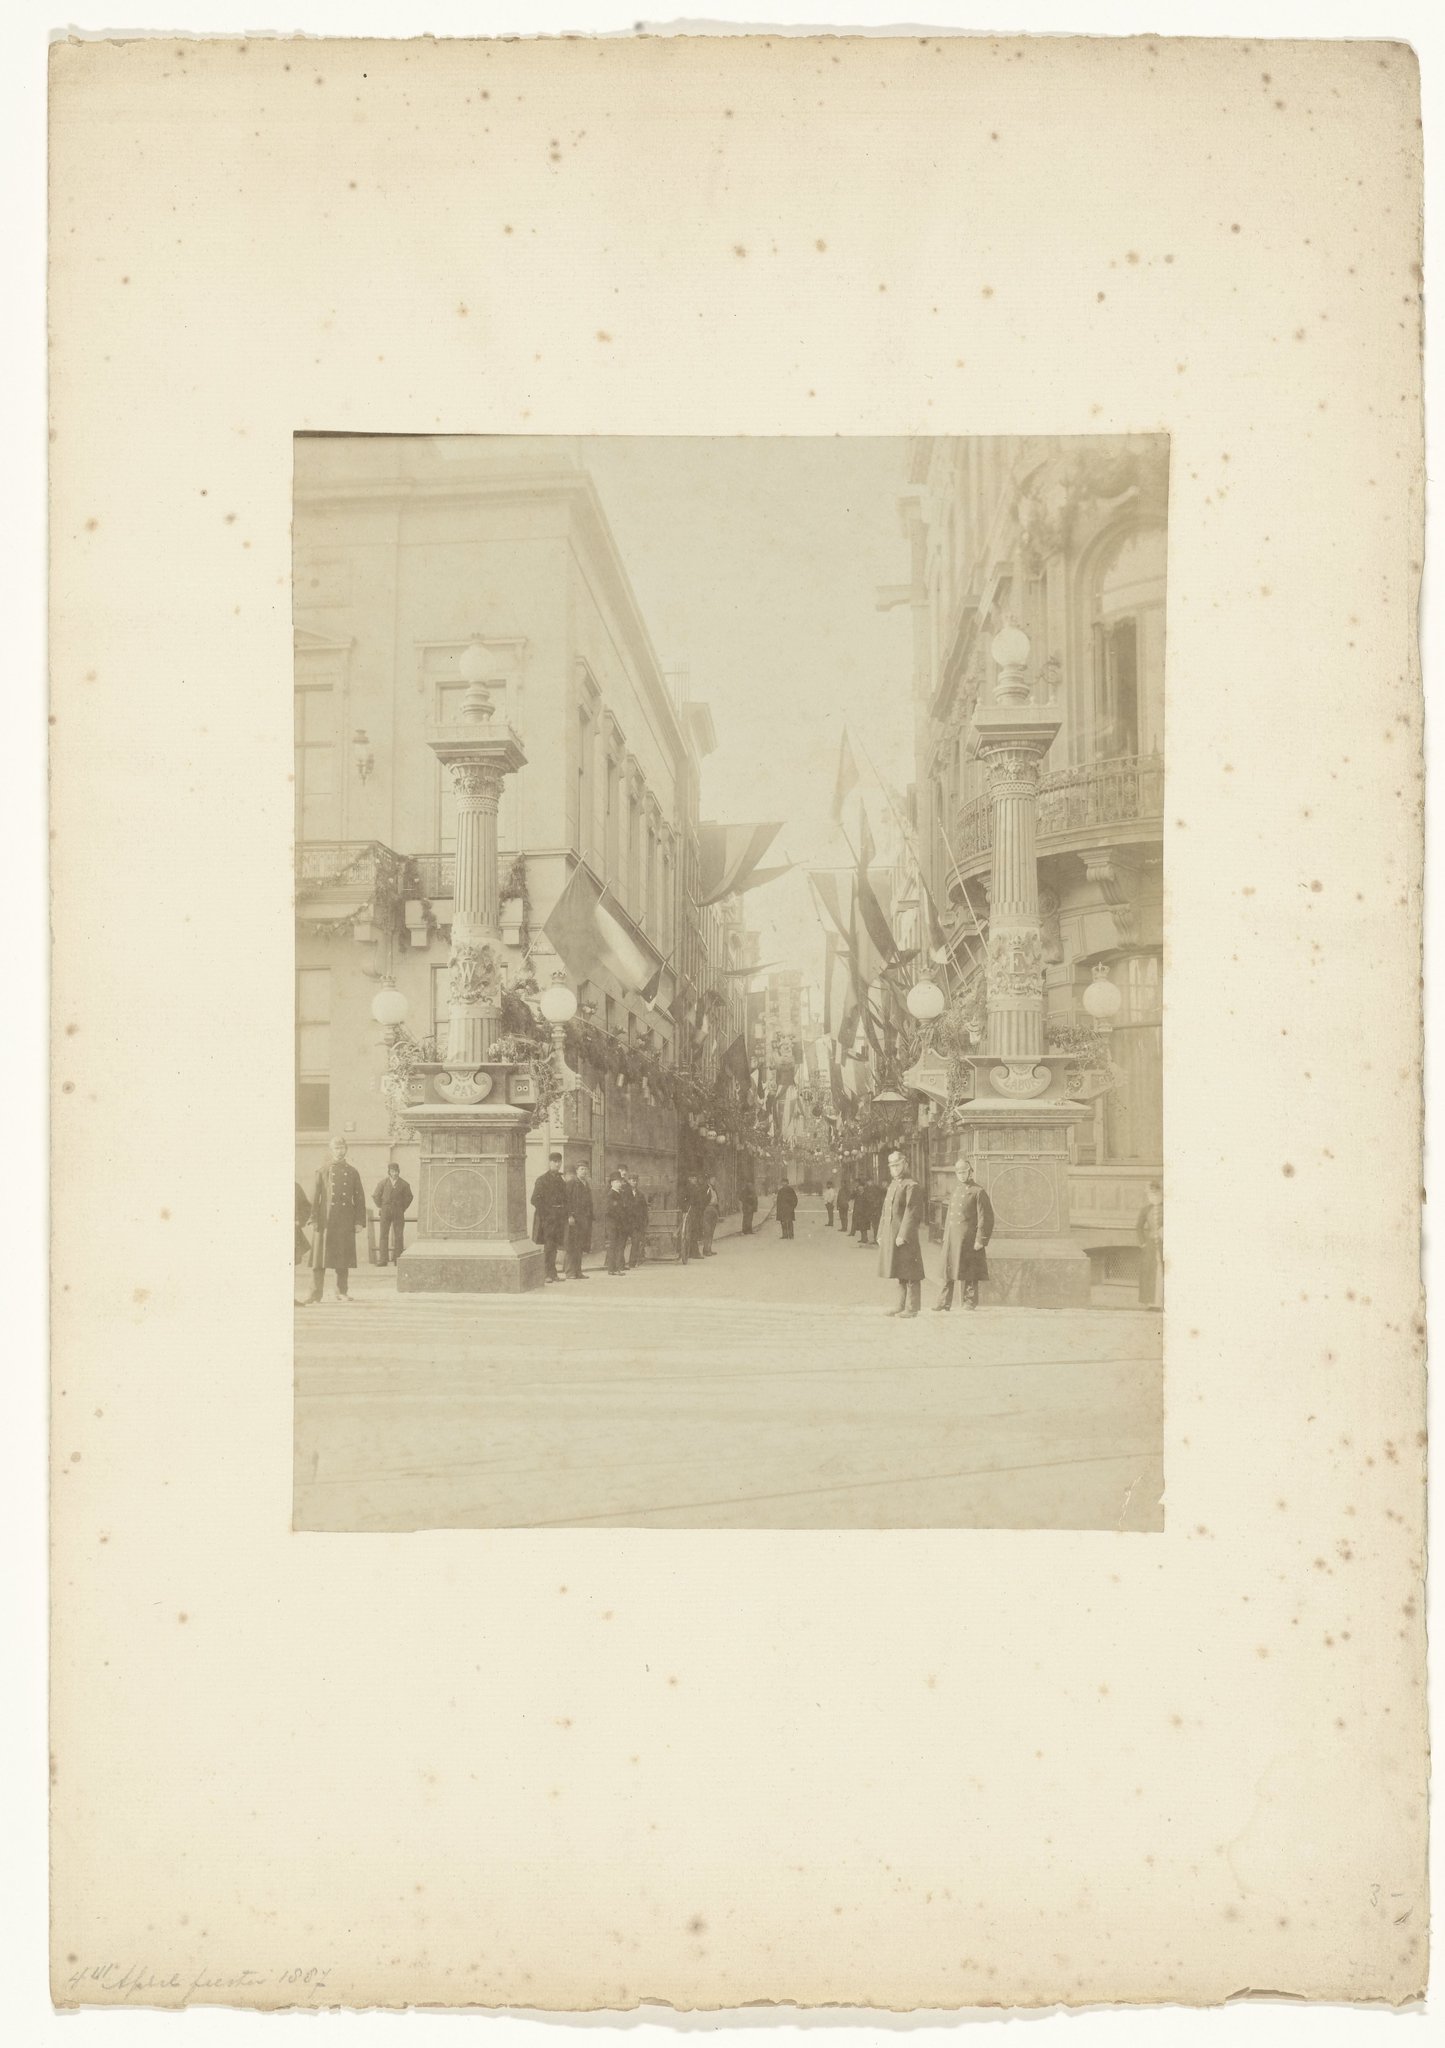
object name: photograph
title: Fot. Henri de Louw hoffotograaf (...)/ April feesten 1887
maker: henri de louw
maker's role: fotograaf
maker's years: 1851-1944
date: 1804-1887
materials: paper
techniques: albumen print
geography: amsterdam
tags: street, festivities, amsterdam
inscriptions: title: ‘Fot. Henri de Louw hoffotograaf .../ April feesten 1887’